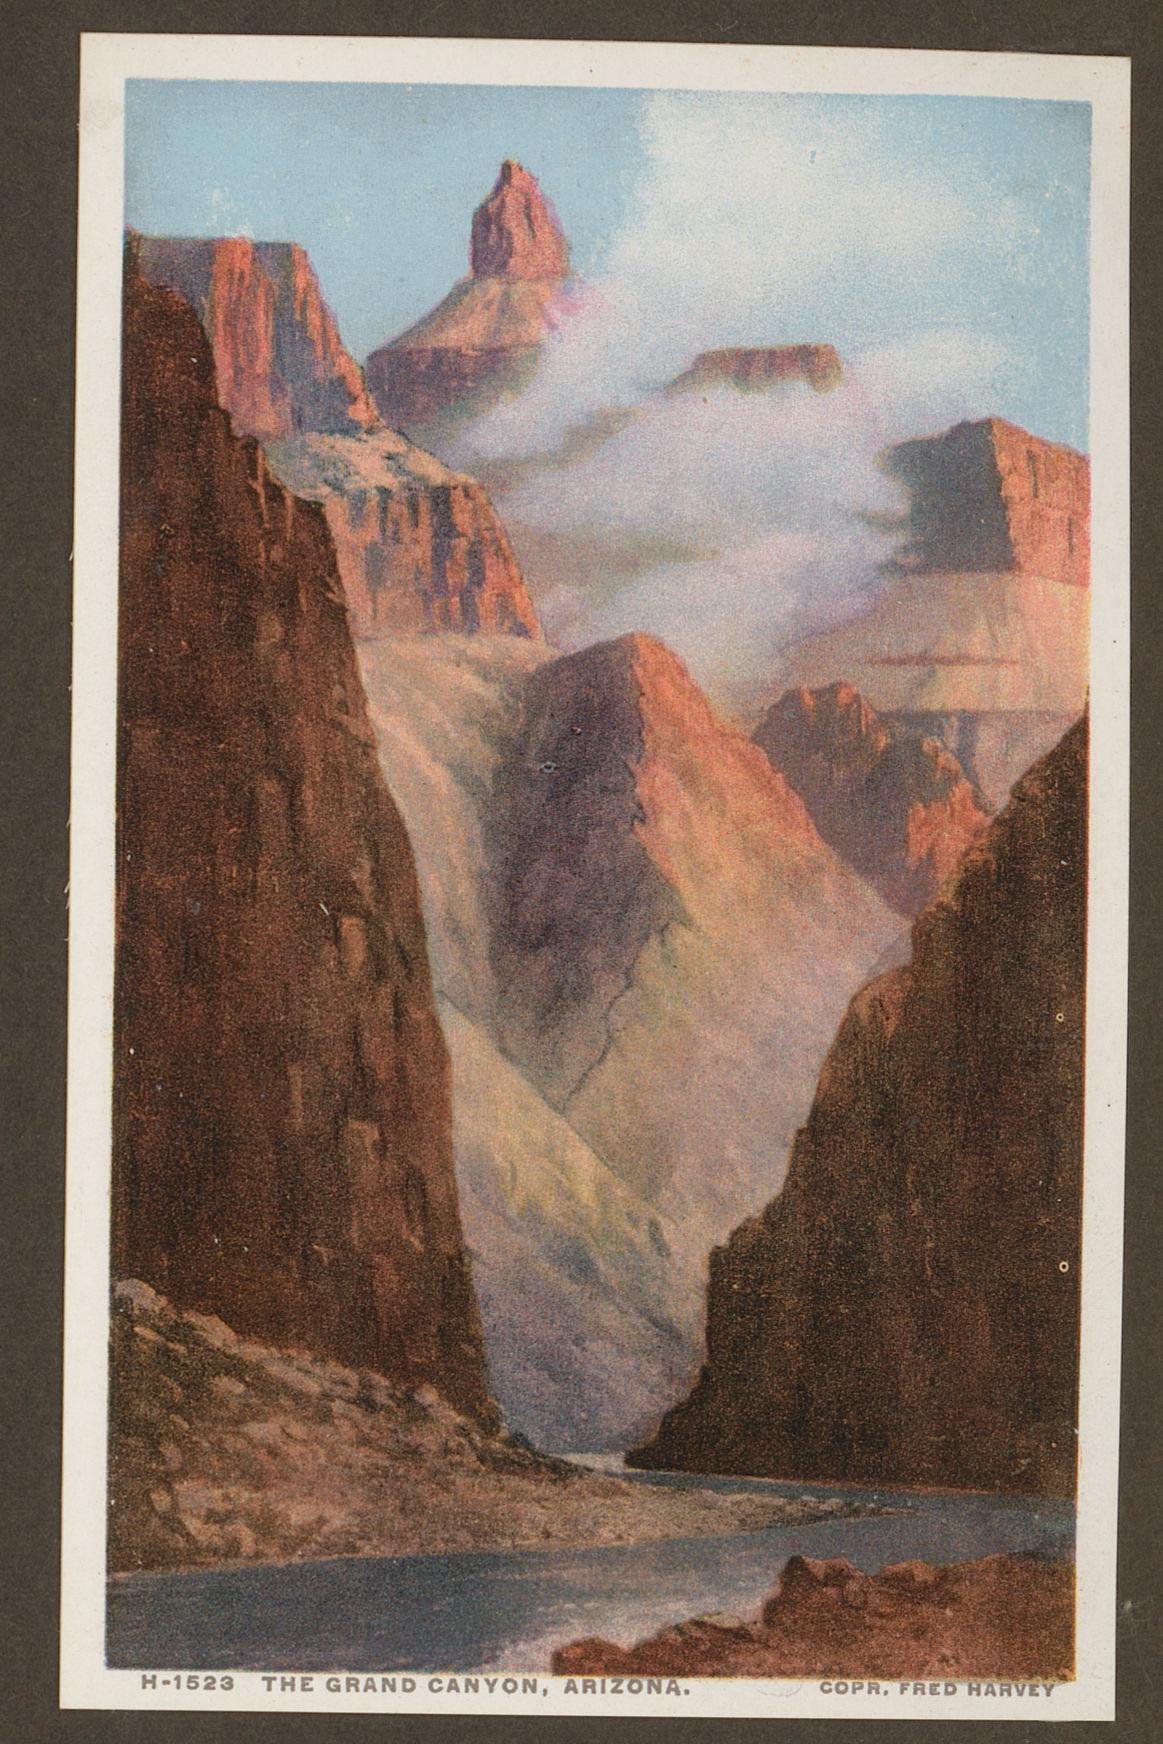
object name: ansichtkaart, prentbriefkaart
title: The Grand Canyon, Arizona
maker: Anonymous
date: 1928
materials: paper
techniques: chromolithography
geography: grand canyon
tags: shop, store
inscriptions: number: ‘H-1523’, annotation: ‘Grand Canyon’